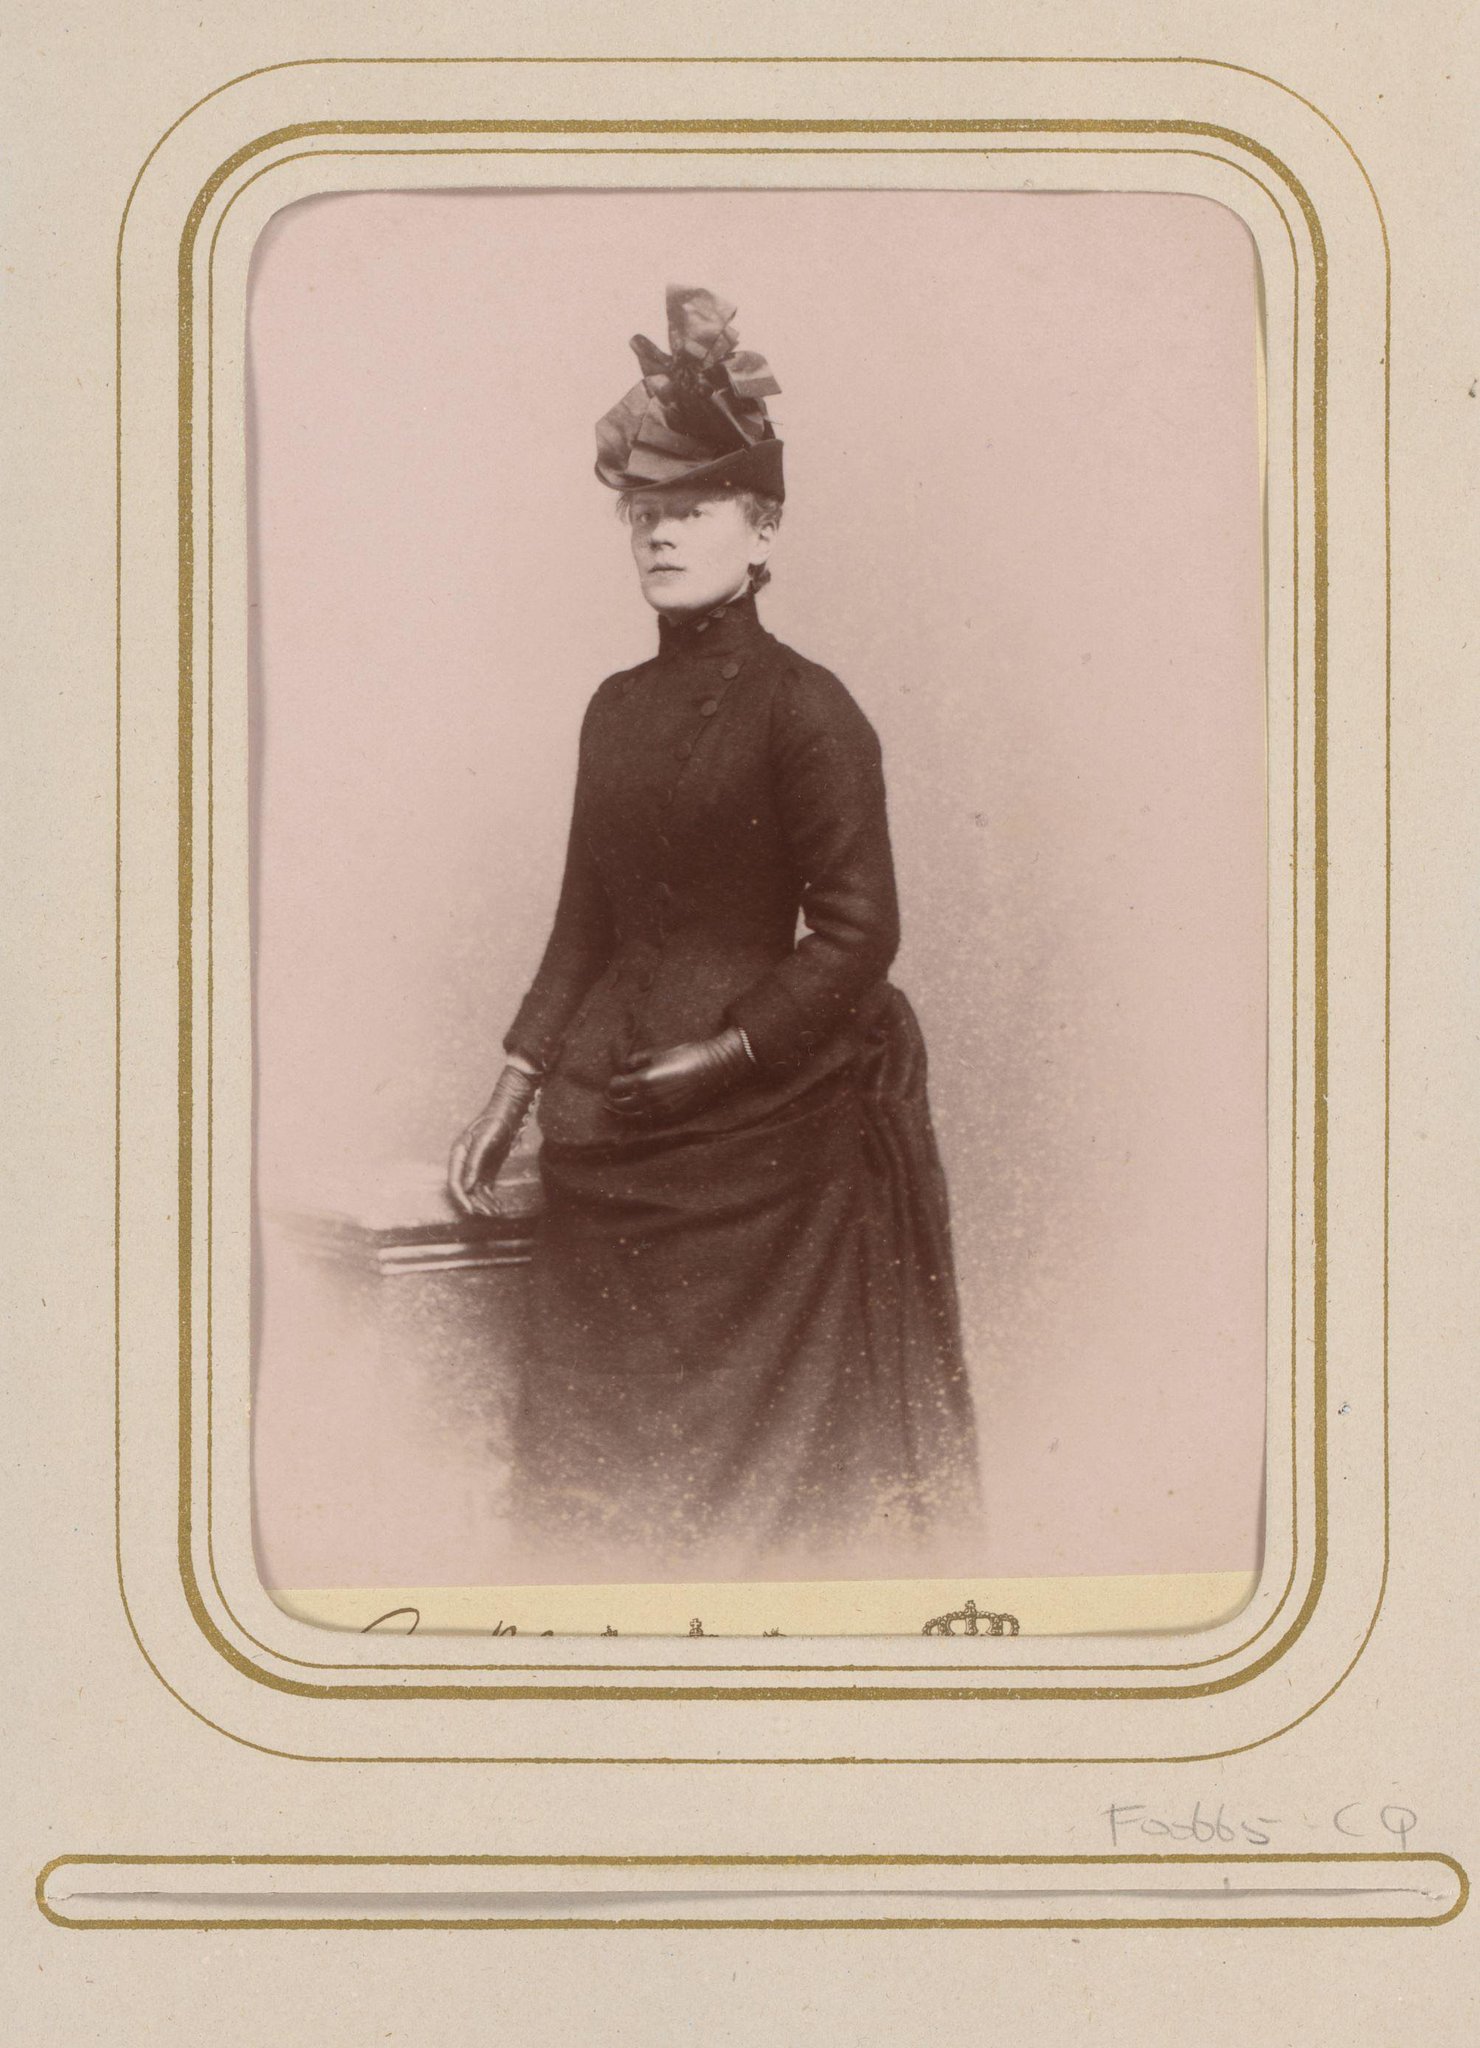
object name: cabinet photograph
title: Portret van een vrouw met hoed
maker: richard kameke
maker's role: fotograaf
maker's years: 1847-1898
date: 1887-1898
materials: cardboard, photographic support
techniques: albumen print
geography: the hague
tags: historical persons - bb - woman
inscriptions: inscription: ‘Kameke (...) 'S Gravenhage/ Javastraat No. 20’